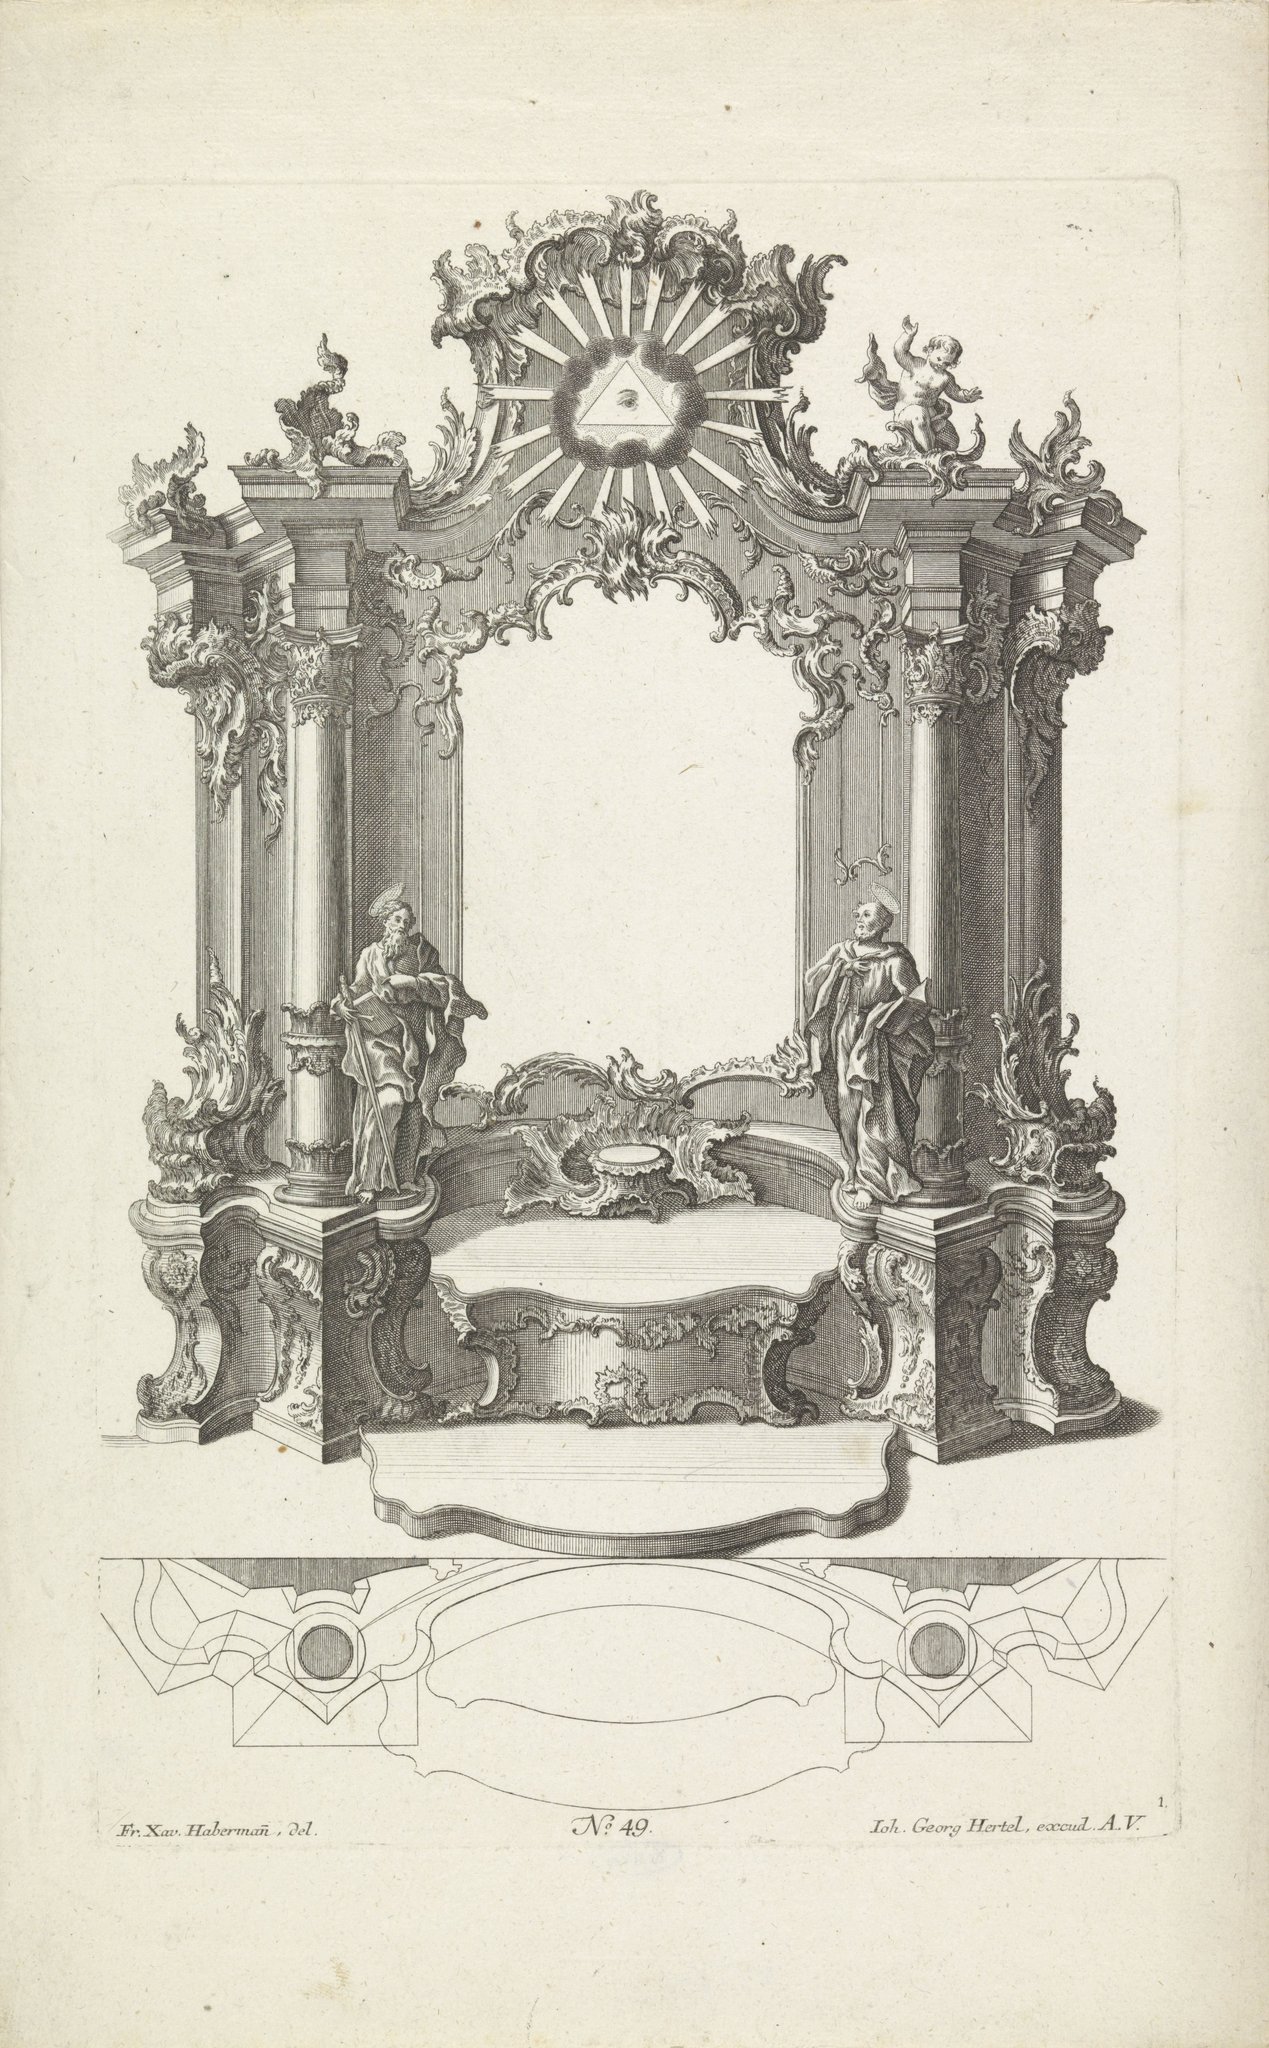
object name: ornament print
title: Altaar met Petrus en Paulus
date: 1740-1745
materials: paper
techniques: engraving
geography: augsburg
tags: the all-seeing eye, triangle with eye ~ symbol of god the father, altar, the apostle peter, first bishop of rome; possible attributes: book, cock, (upturned) cross, (triple) crozier, fish, key, scroll, ship, tiara, the apostle paul of tarsus; possible attributes: book, scroll, sword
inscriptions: collector's mark: Lugt 2228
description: Ontwerp en plattegrond van altaar met rocaille ornamenten. Links en rechts Paulus met zwaard en boek en Petrus met sleutel. Bovenin het alziend oog omgeven door stralen. Uitgeversnummer 49.